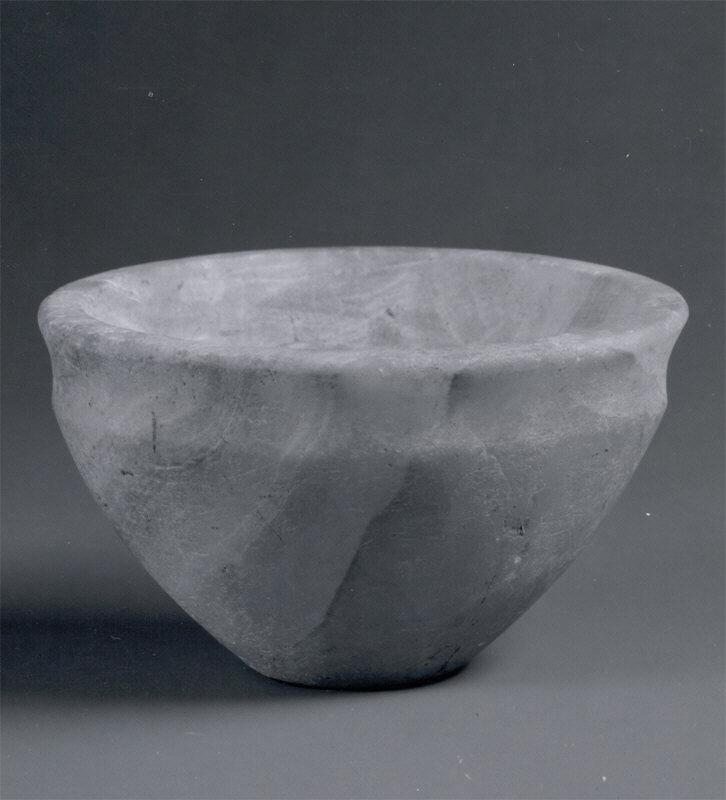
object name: bowl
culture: bactria-margiana archaeological complex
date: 2333-1668 BCE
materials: marble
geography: bactria-margiana